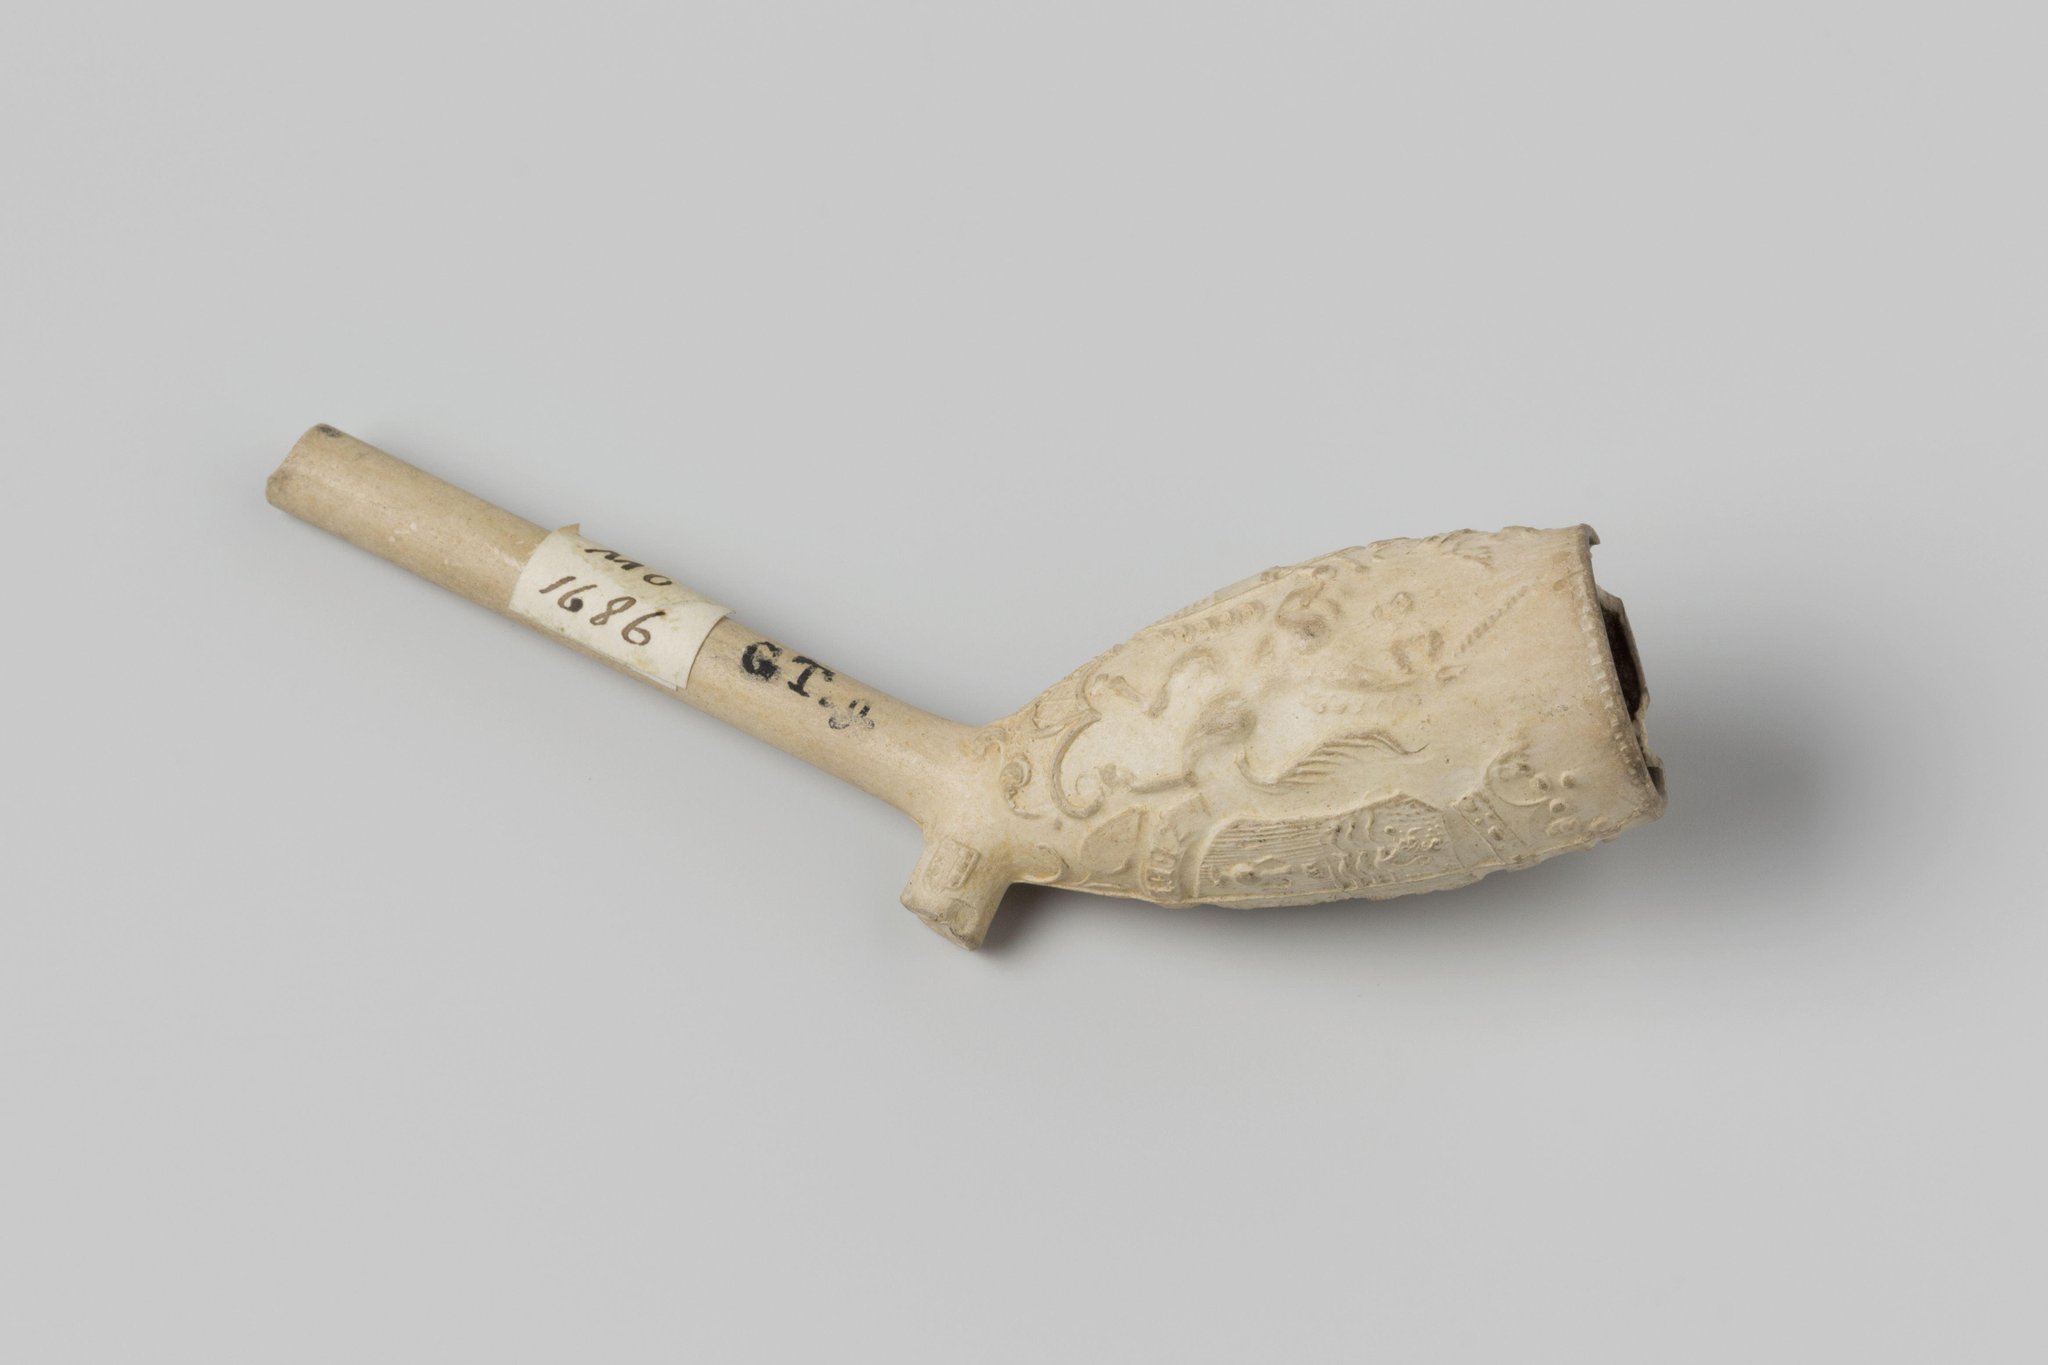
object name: pipe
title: Pijpenkop.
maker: Anonymous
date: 1400-1950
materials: clay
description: Gedeelte van een rookpijp met het wapen van Zeeland.